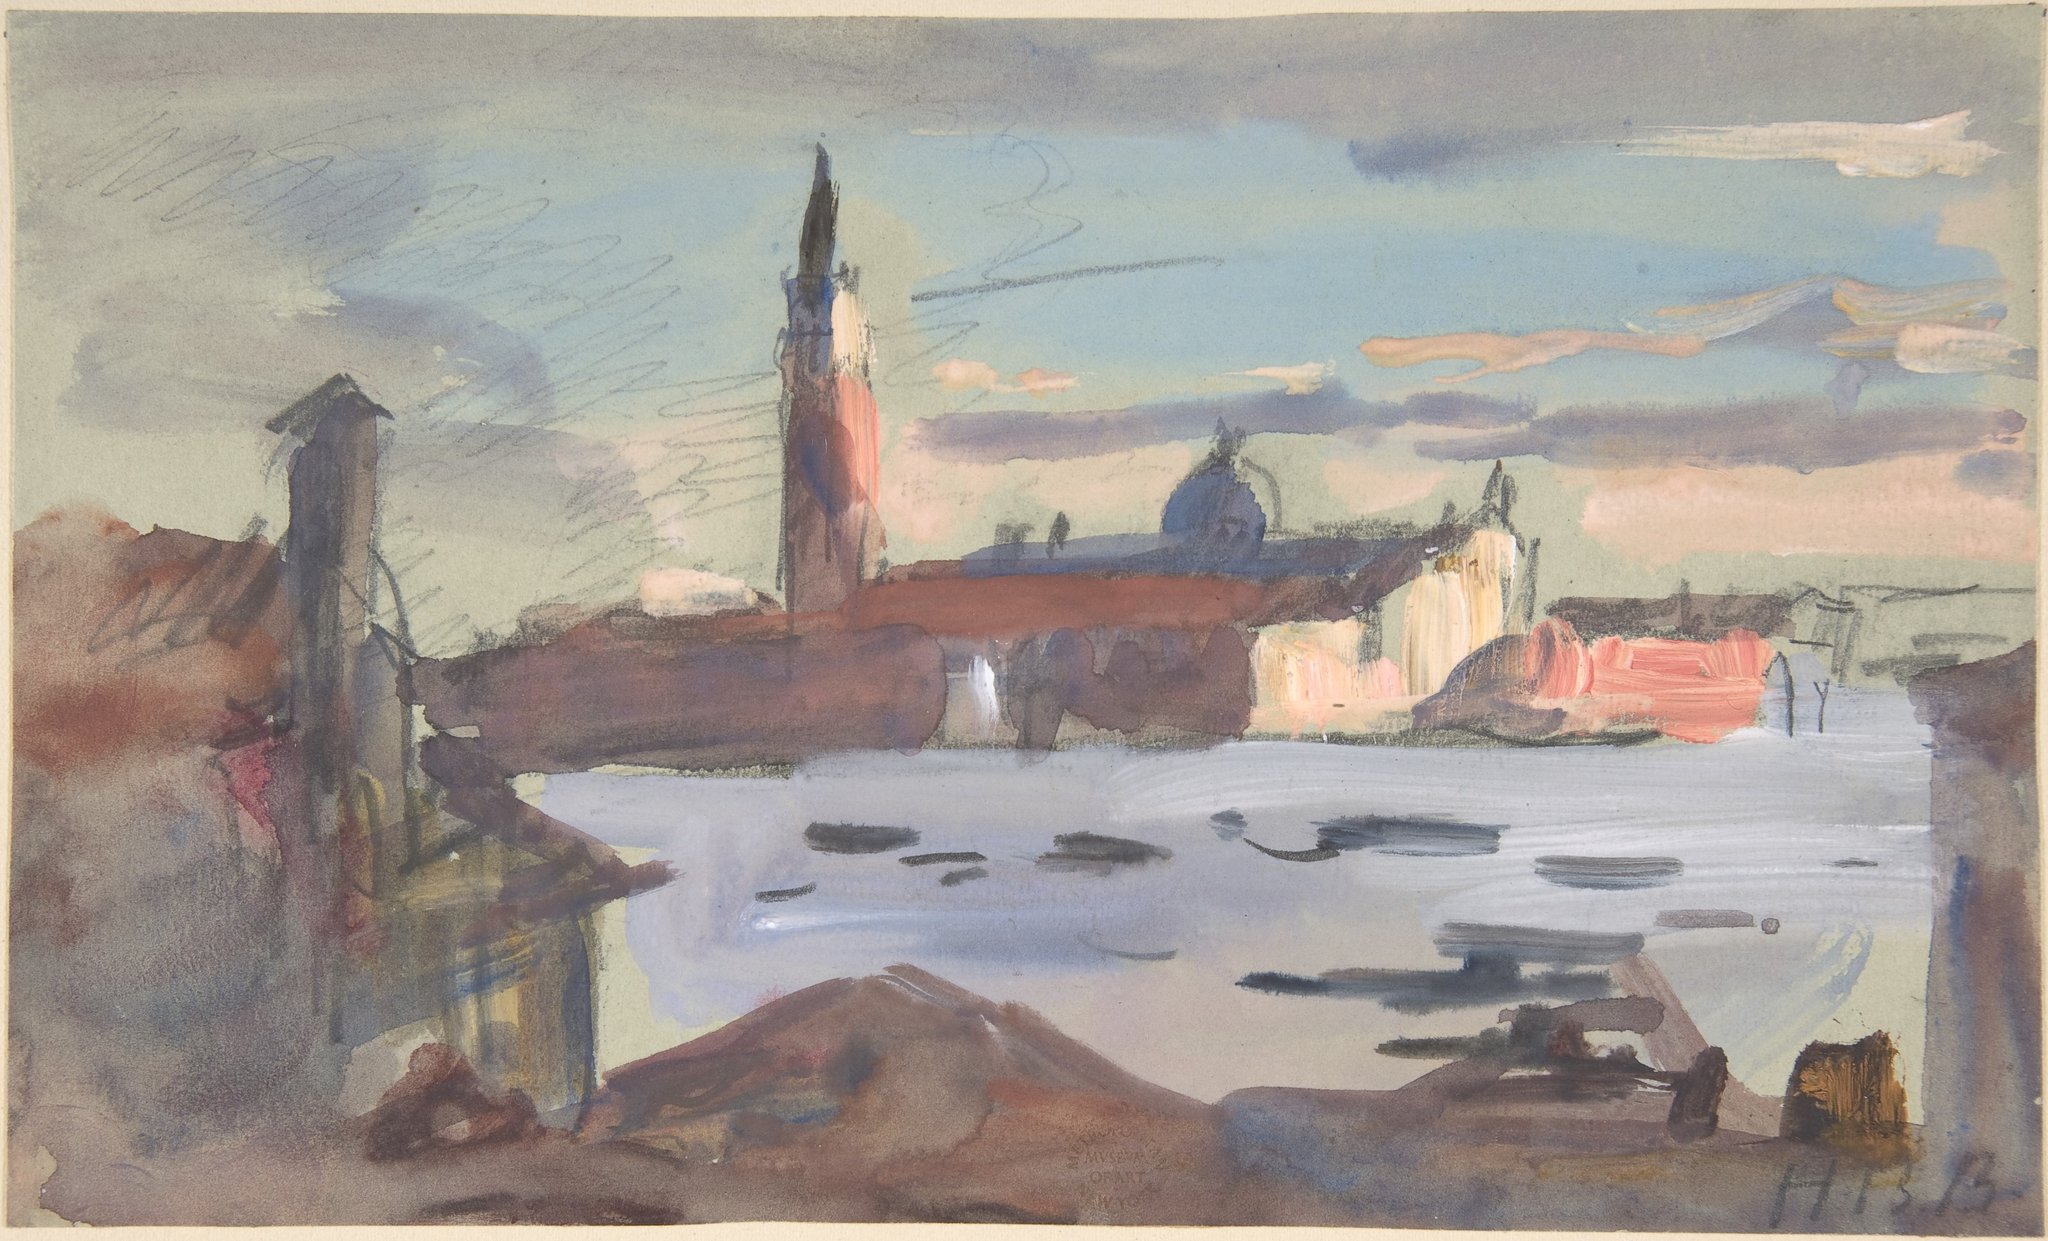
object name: drawing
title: San Giorgio Maggiore, Venice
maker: hercules brabazon brabazon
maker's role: artist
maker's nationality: british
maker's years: 1821-1906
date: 1840-1906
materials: gouache, graphite, watercolor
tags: churches,venice